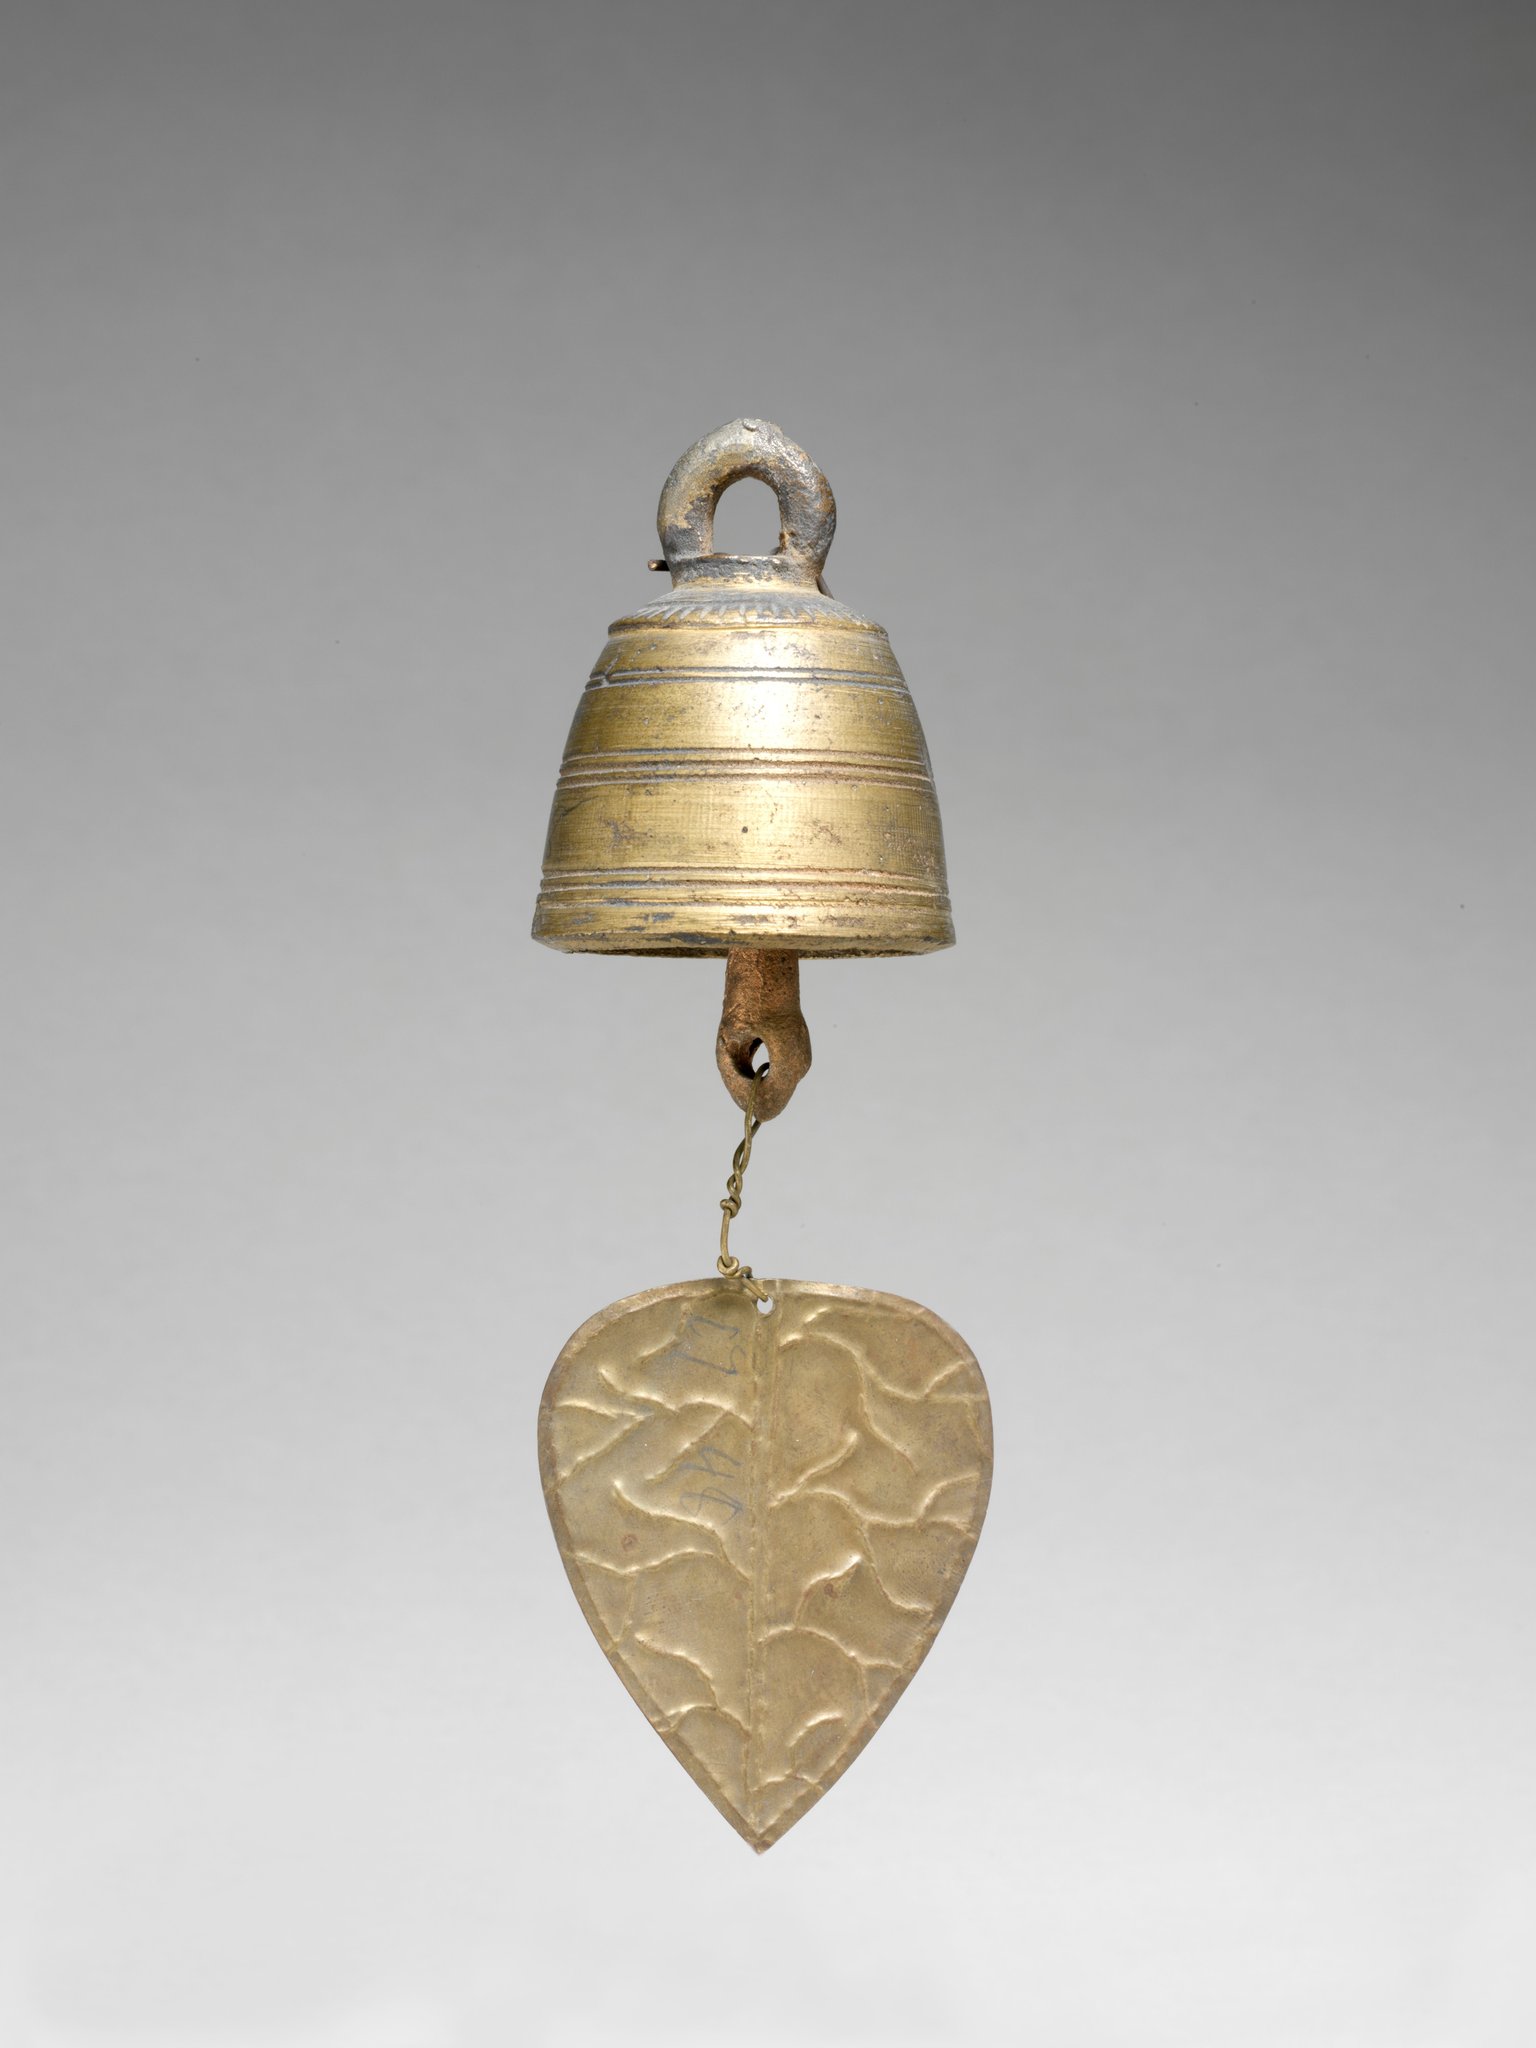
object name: khew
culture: burmese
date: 1867-1900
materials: metal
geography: myanmar